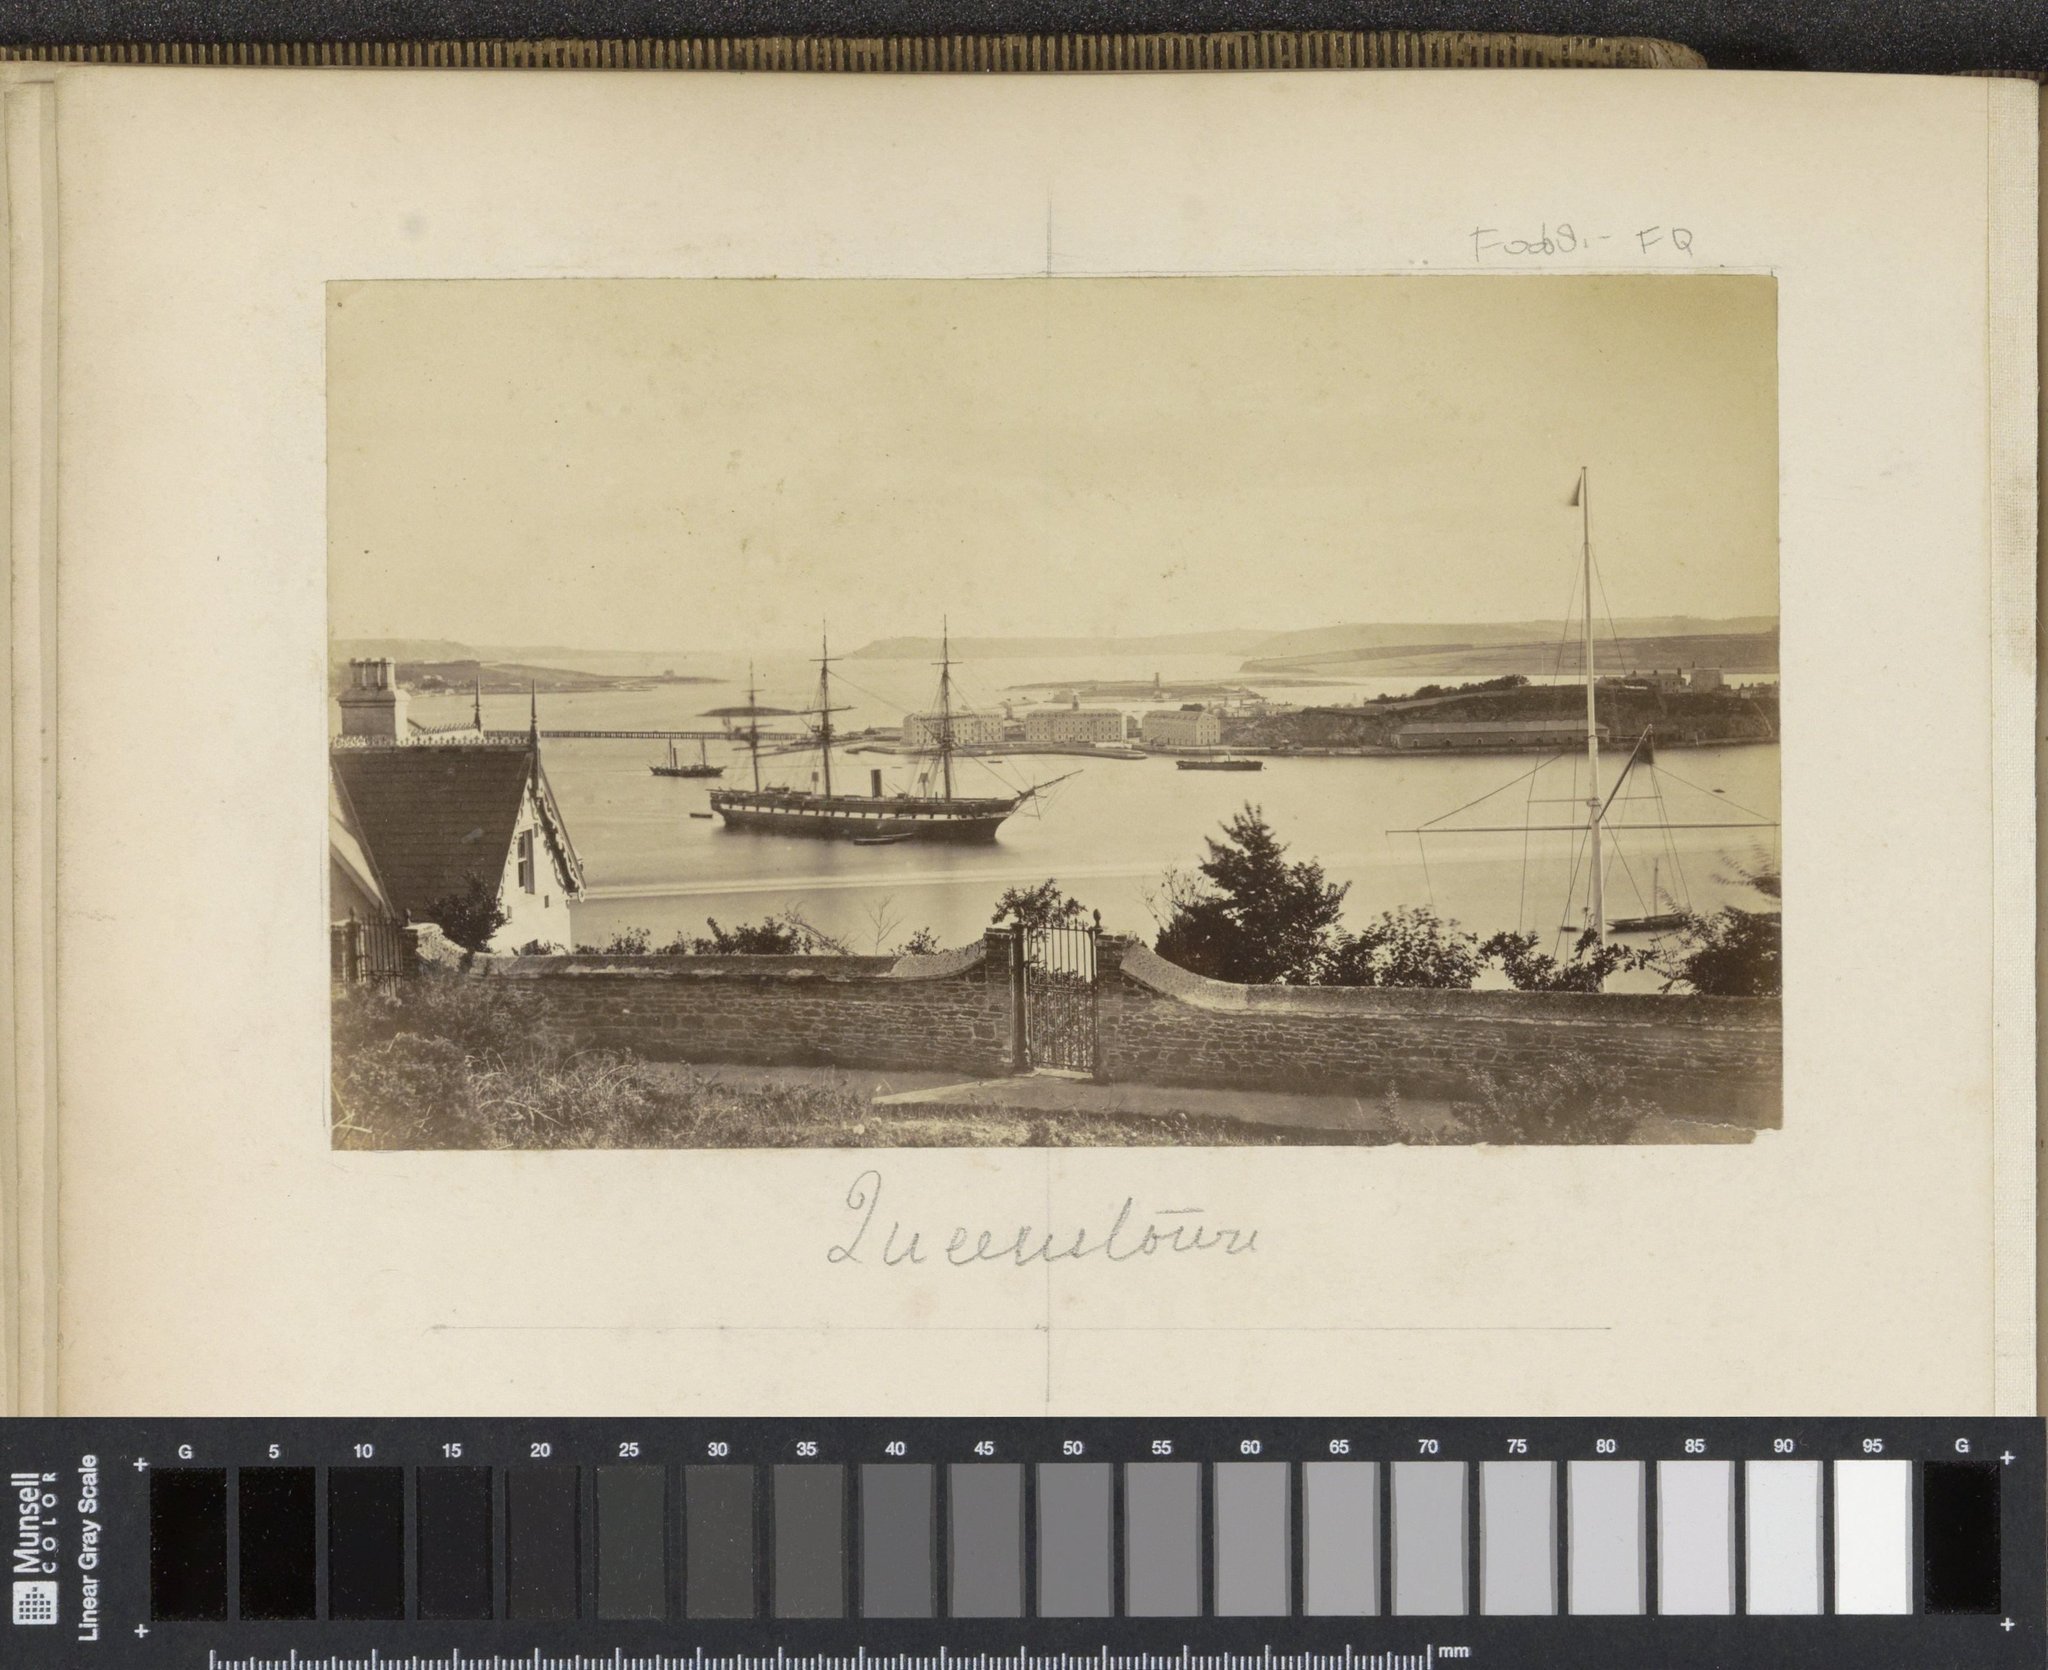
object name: photograph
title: Gezicht op een haven aan de kust, vermoedelijk in Engeland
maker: Anonymous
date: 1850-1870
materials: paper, photographic support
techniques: albumen print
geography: england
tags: harbour (+ view ~ vehicle, ship, etc.), england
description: Onderdeel van Album met foto's van bezienswaardigheden en landschappen in Engeland en van kunst.